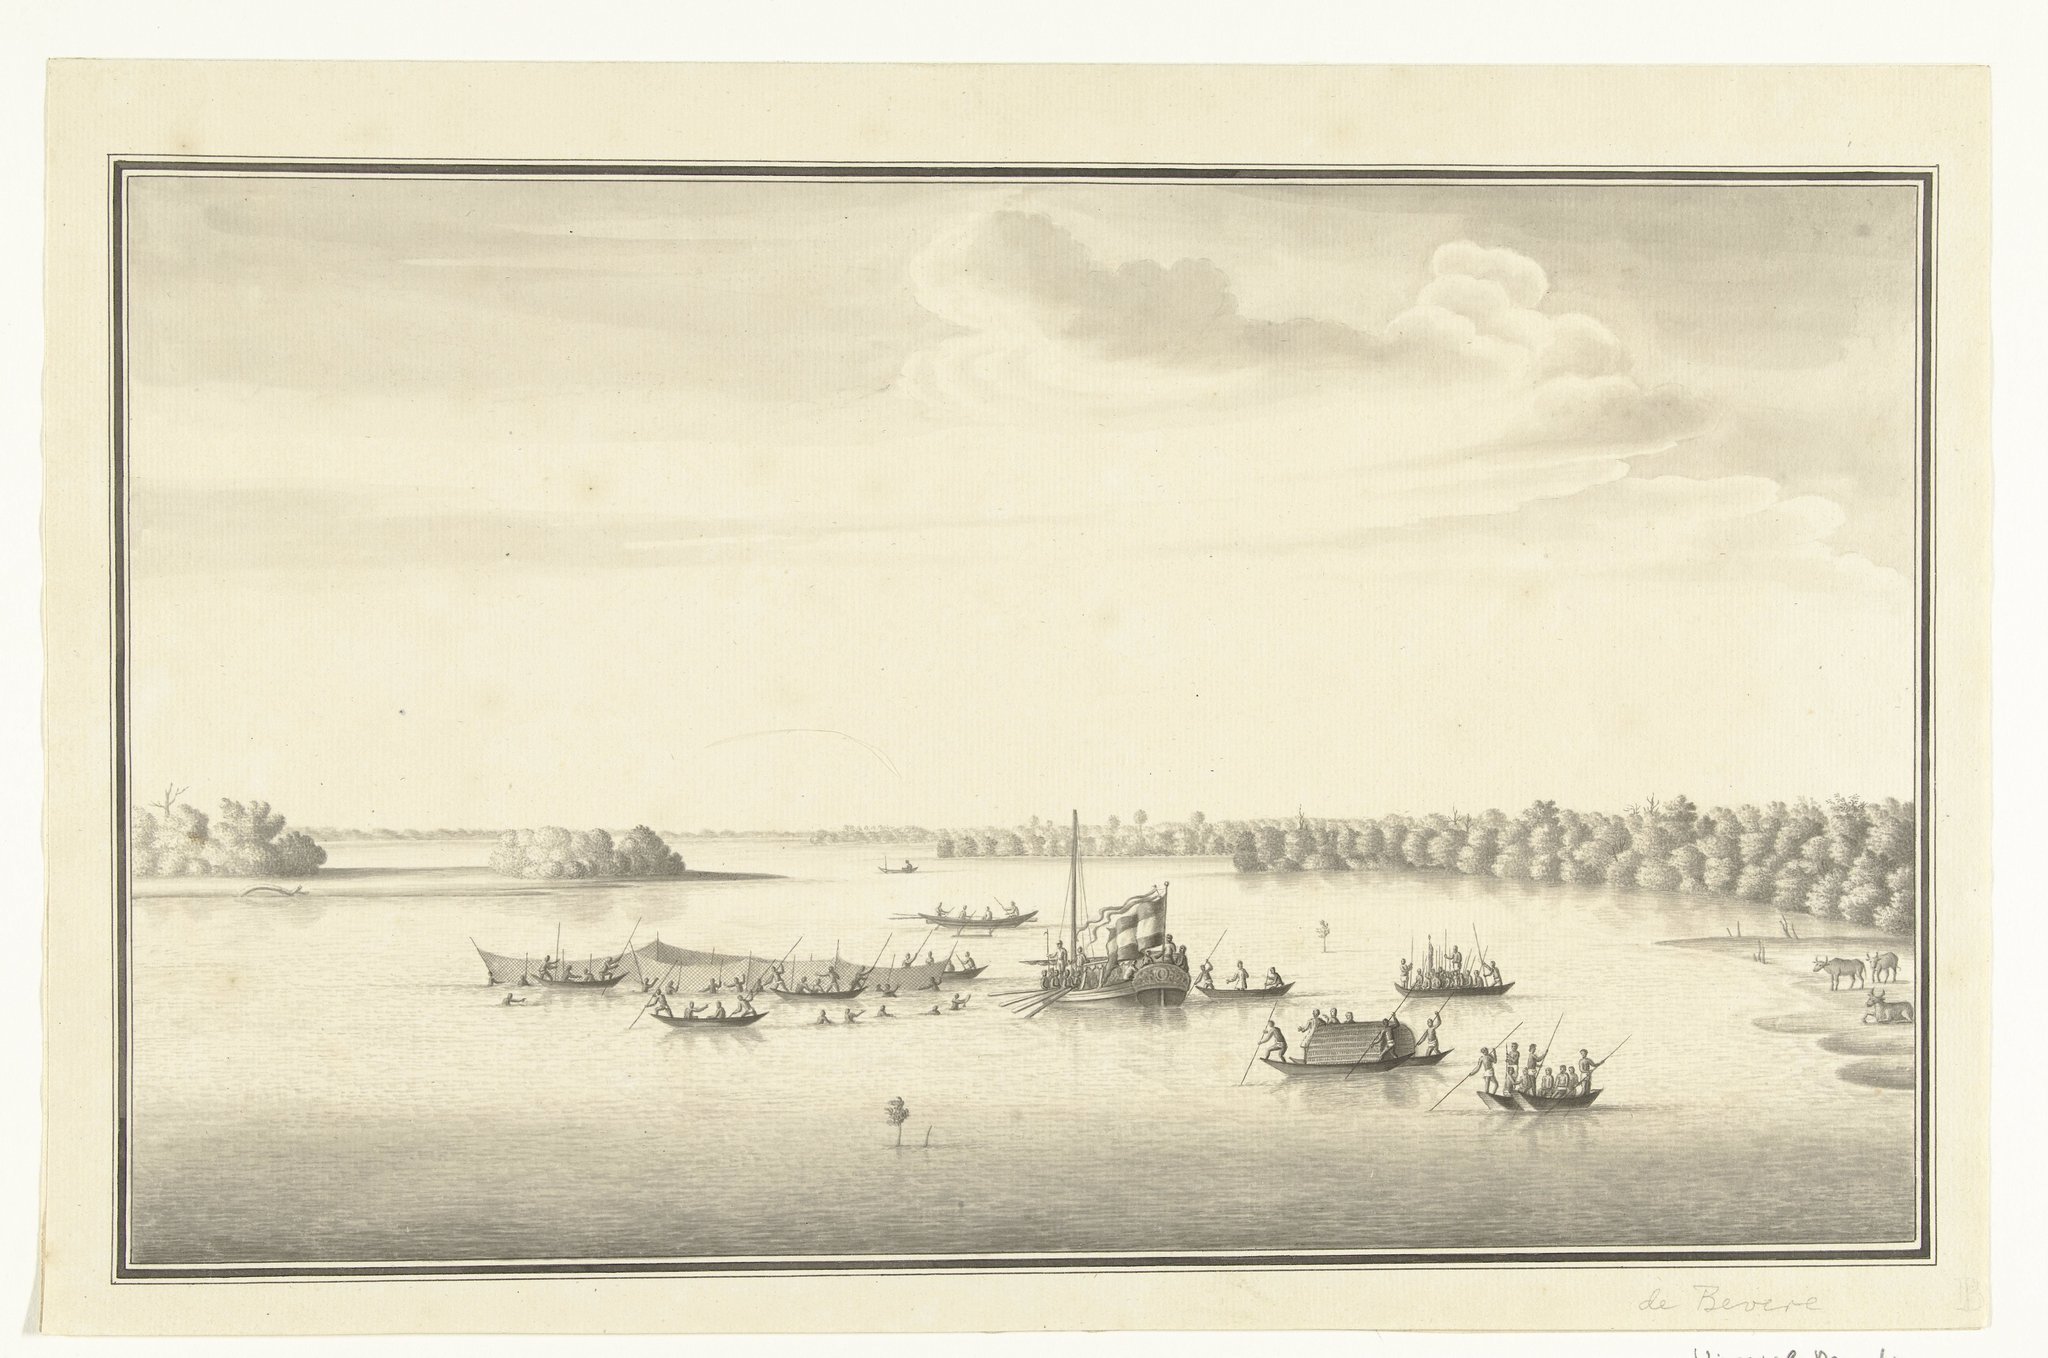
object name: drawing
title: Governor Loten and his Entourage on Negombo Lagoon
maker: pieter de bevere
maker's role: draughtsman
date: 1754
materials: ink, paper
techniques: brush, pen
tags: utrecht, mayor, johan gideon loten, historical persons, sri lanka